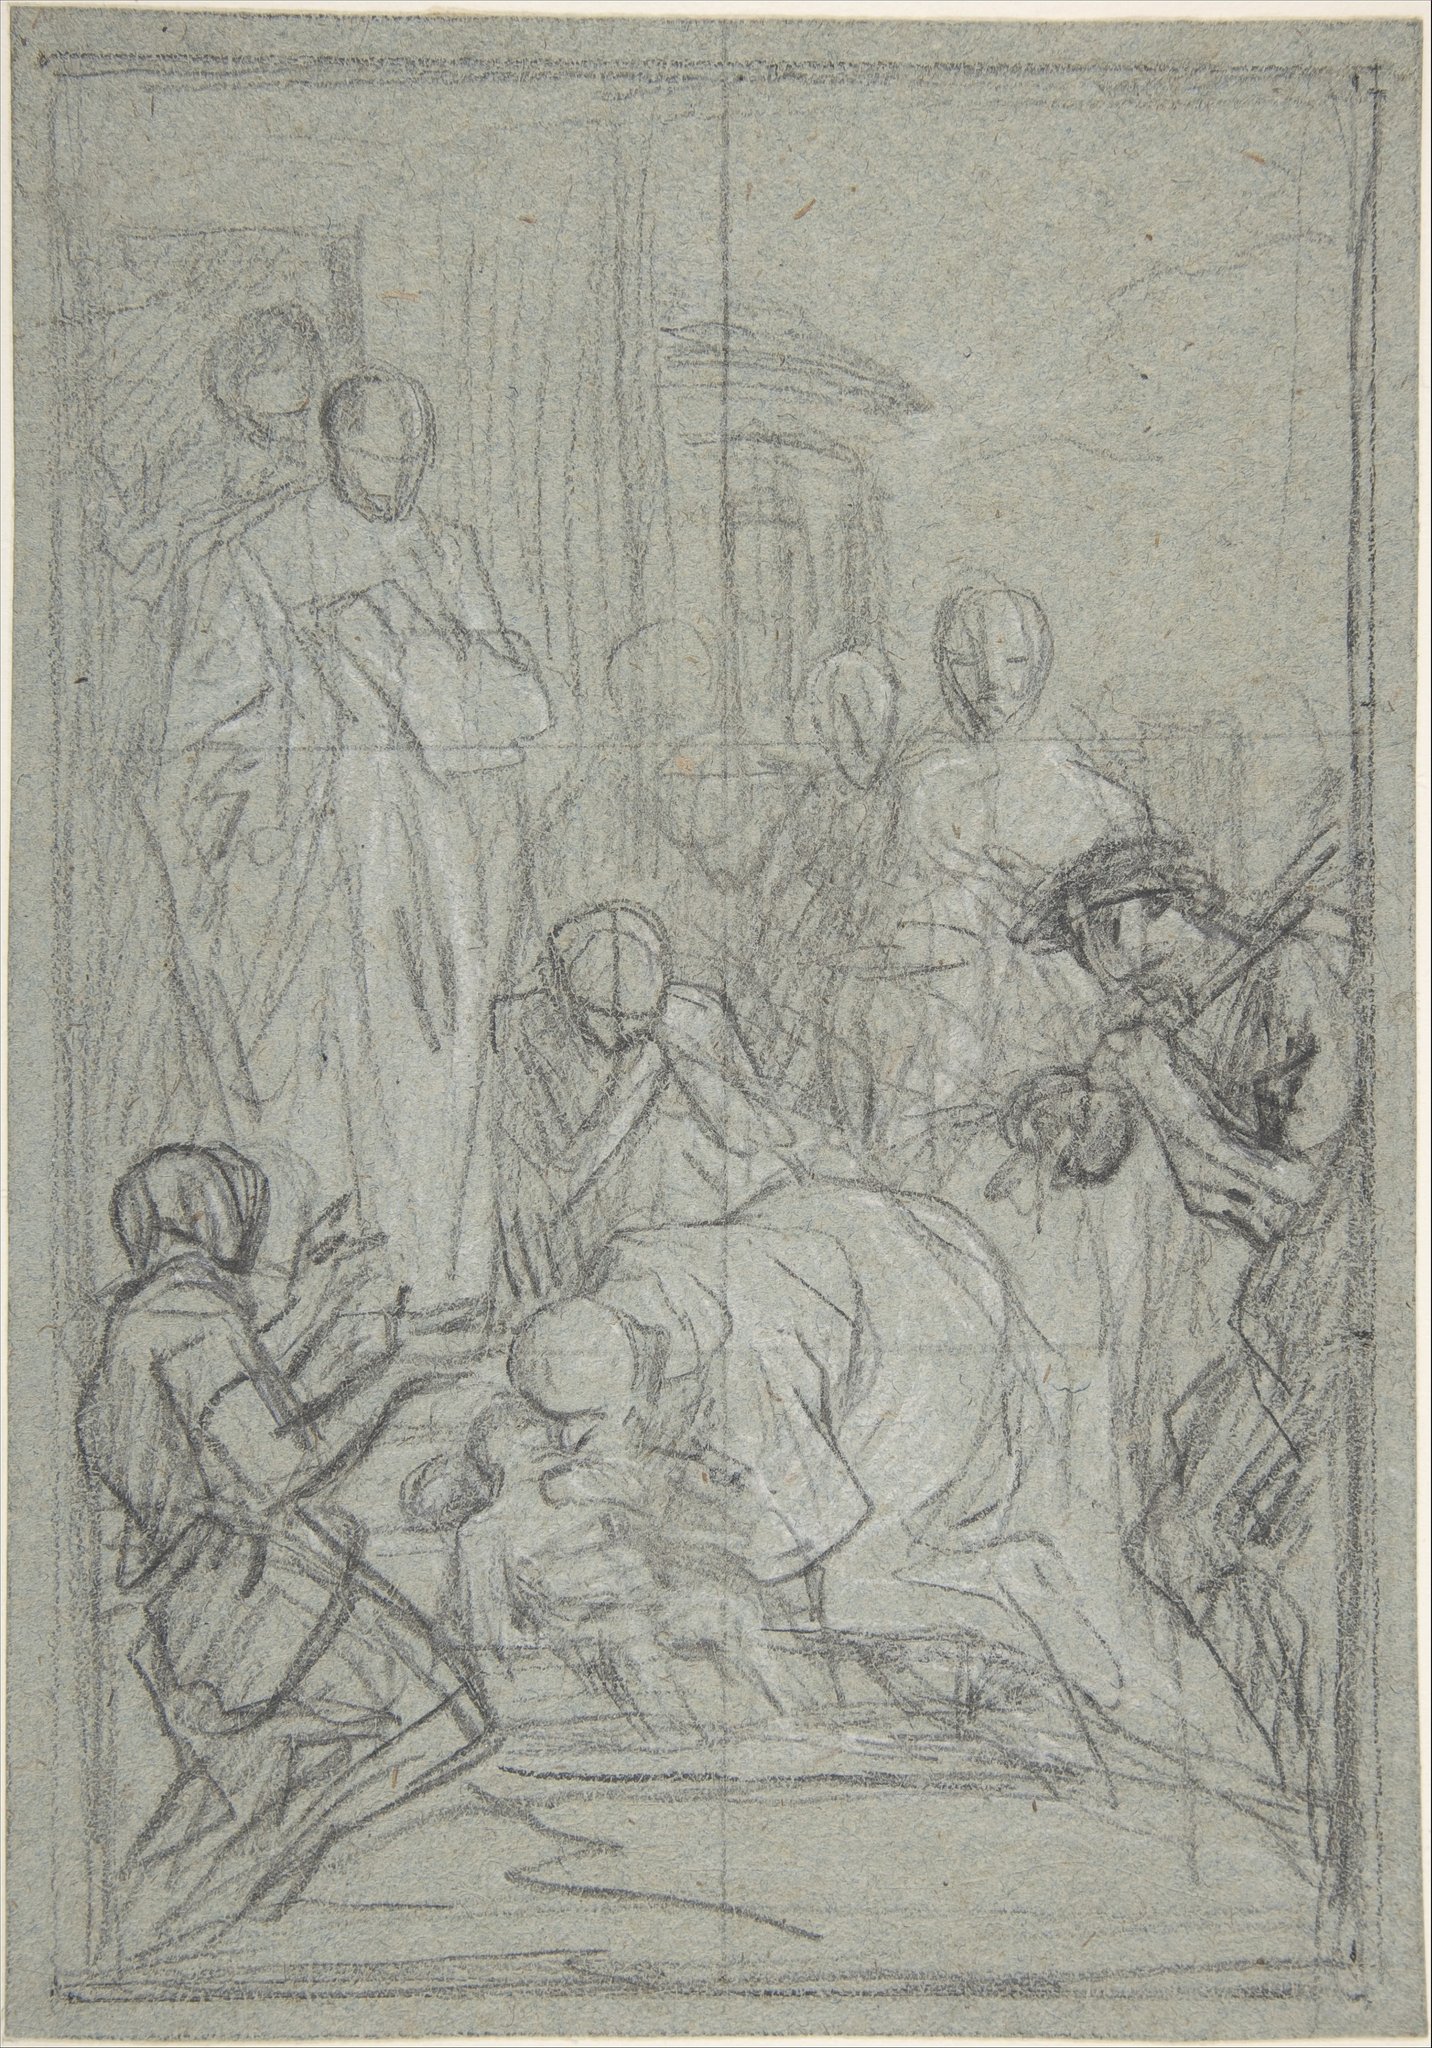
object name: drawing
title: St. Benedict Resuscitating an Infant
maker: pierre hubert subleyras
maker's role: artist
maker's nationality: french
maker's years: 1699-1749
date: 1745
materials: chalk, paper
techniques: heightening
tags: infants,men,saints